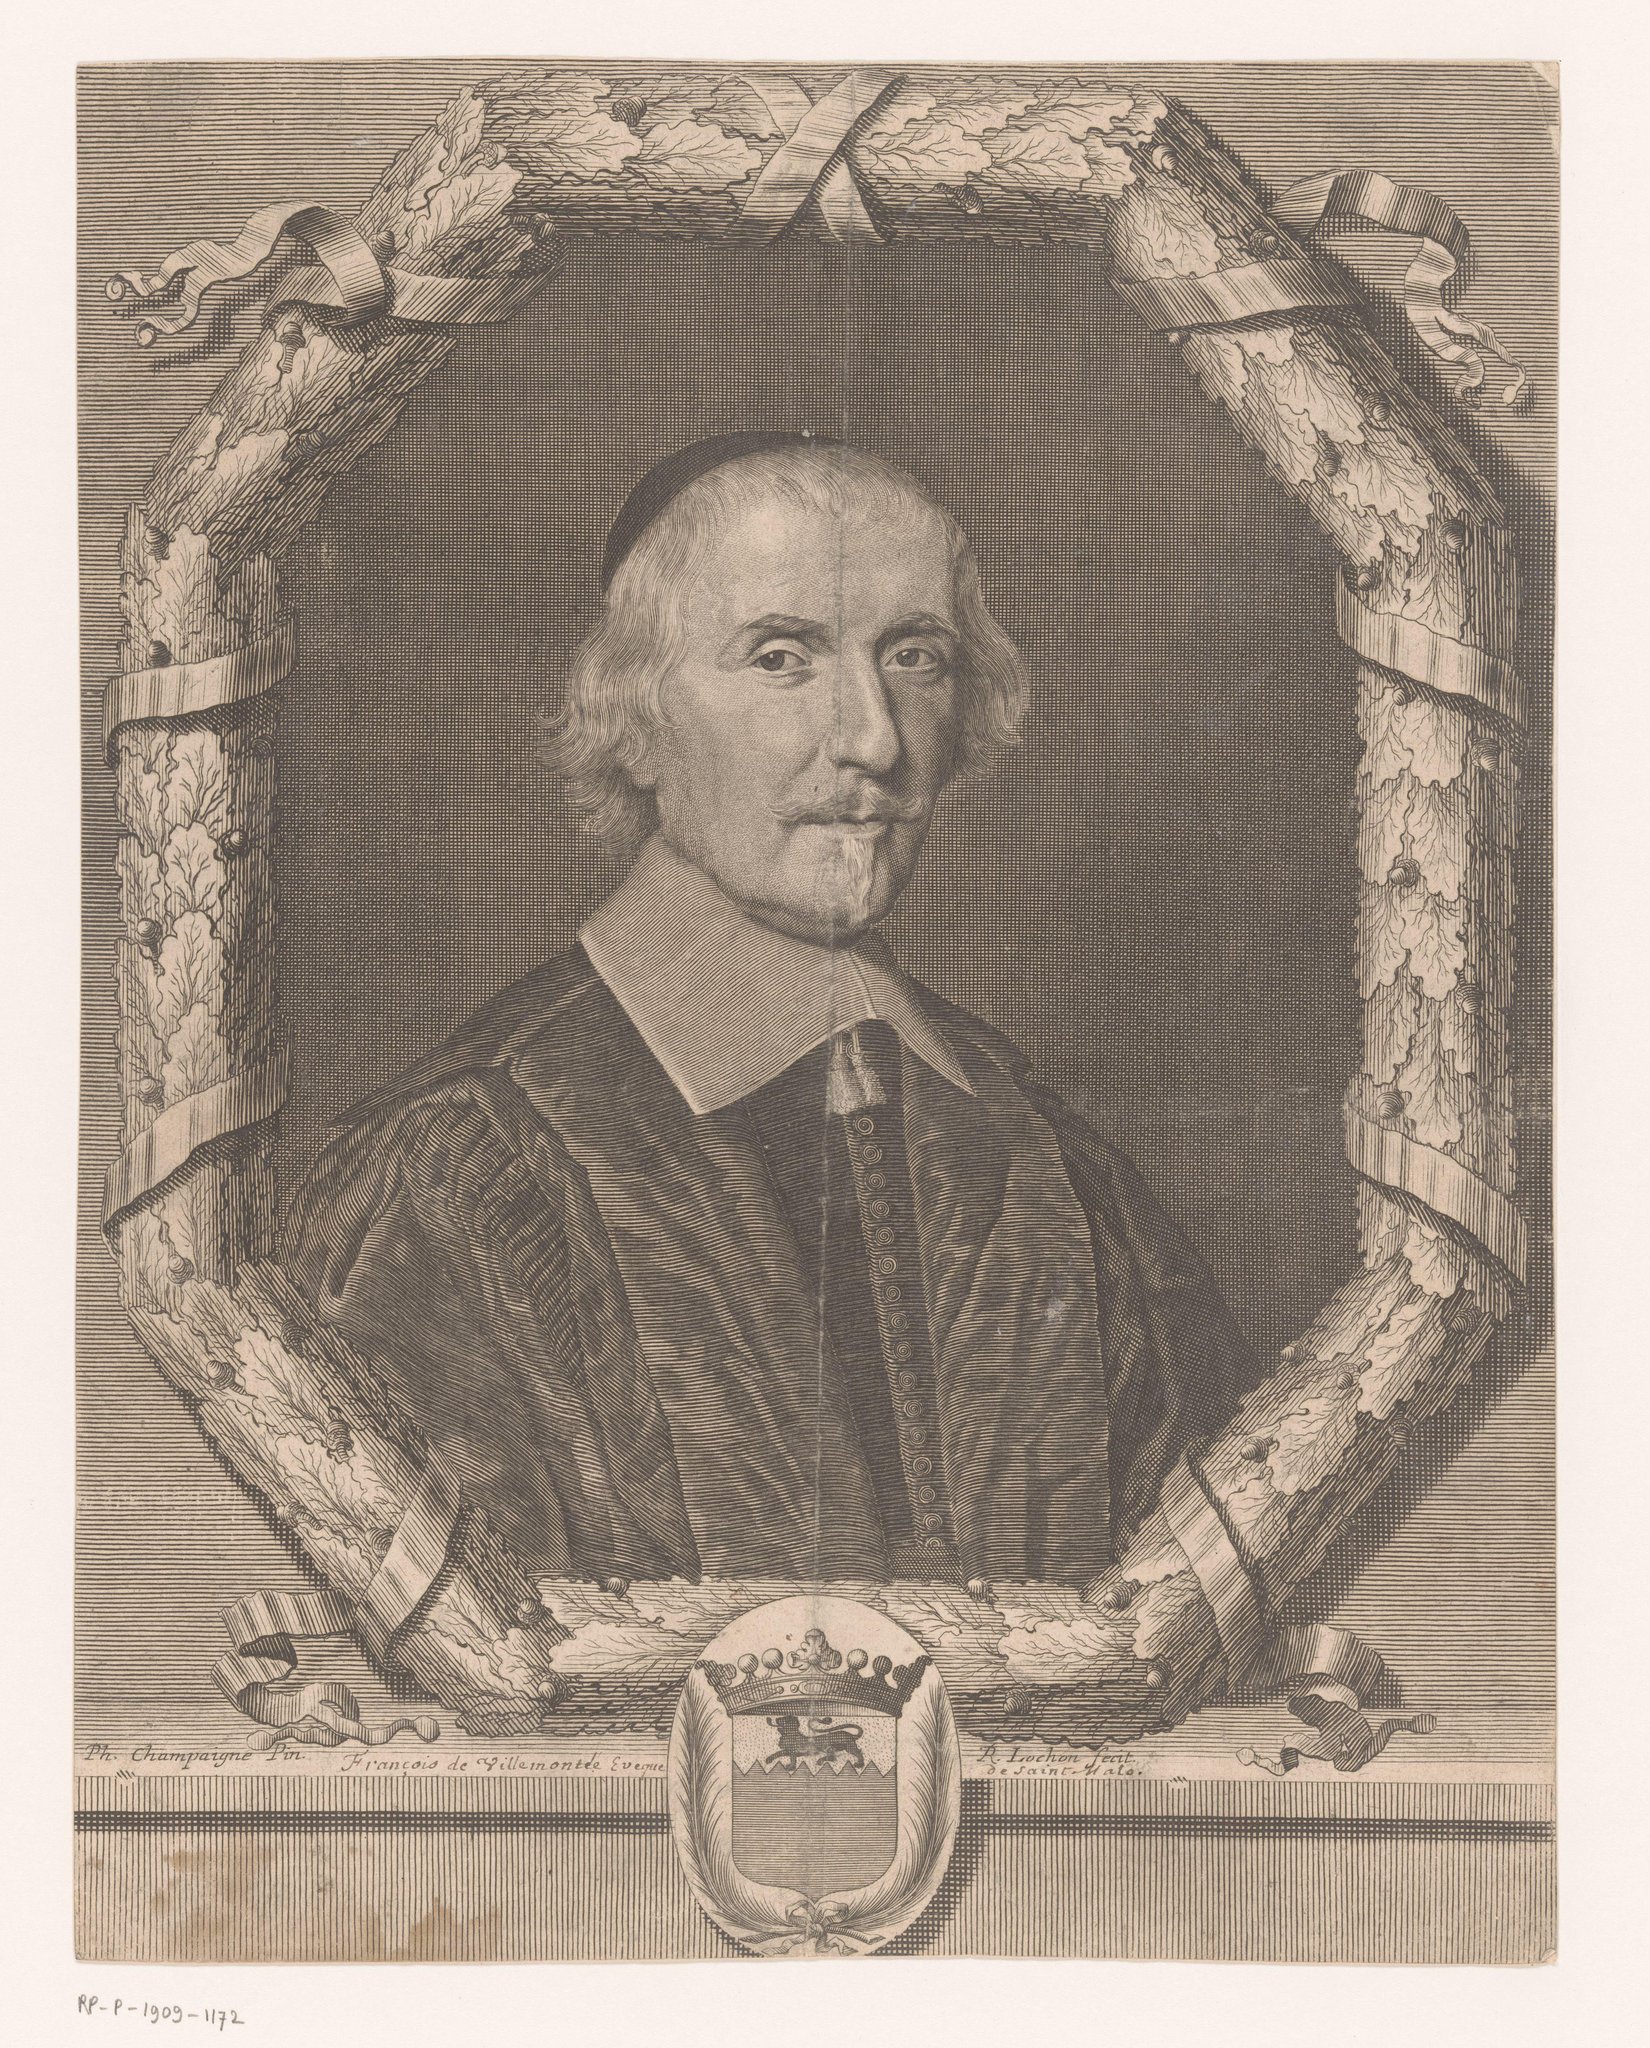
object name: print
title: Portret van François de Villemontée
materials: paper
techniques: engraving, etching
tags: paris, archbishop, bishop, etc. (roman catholic), historical persons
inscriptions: collector's mark: Lugt 2228, inscription: ‘François de Villemontée Eveque de Saint Malo’